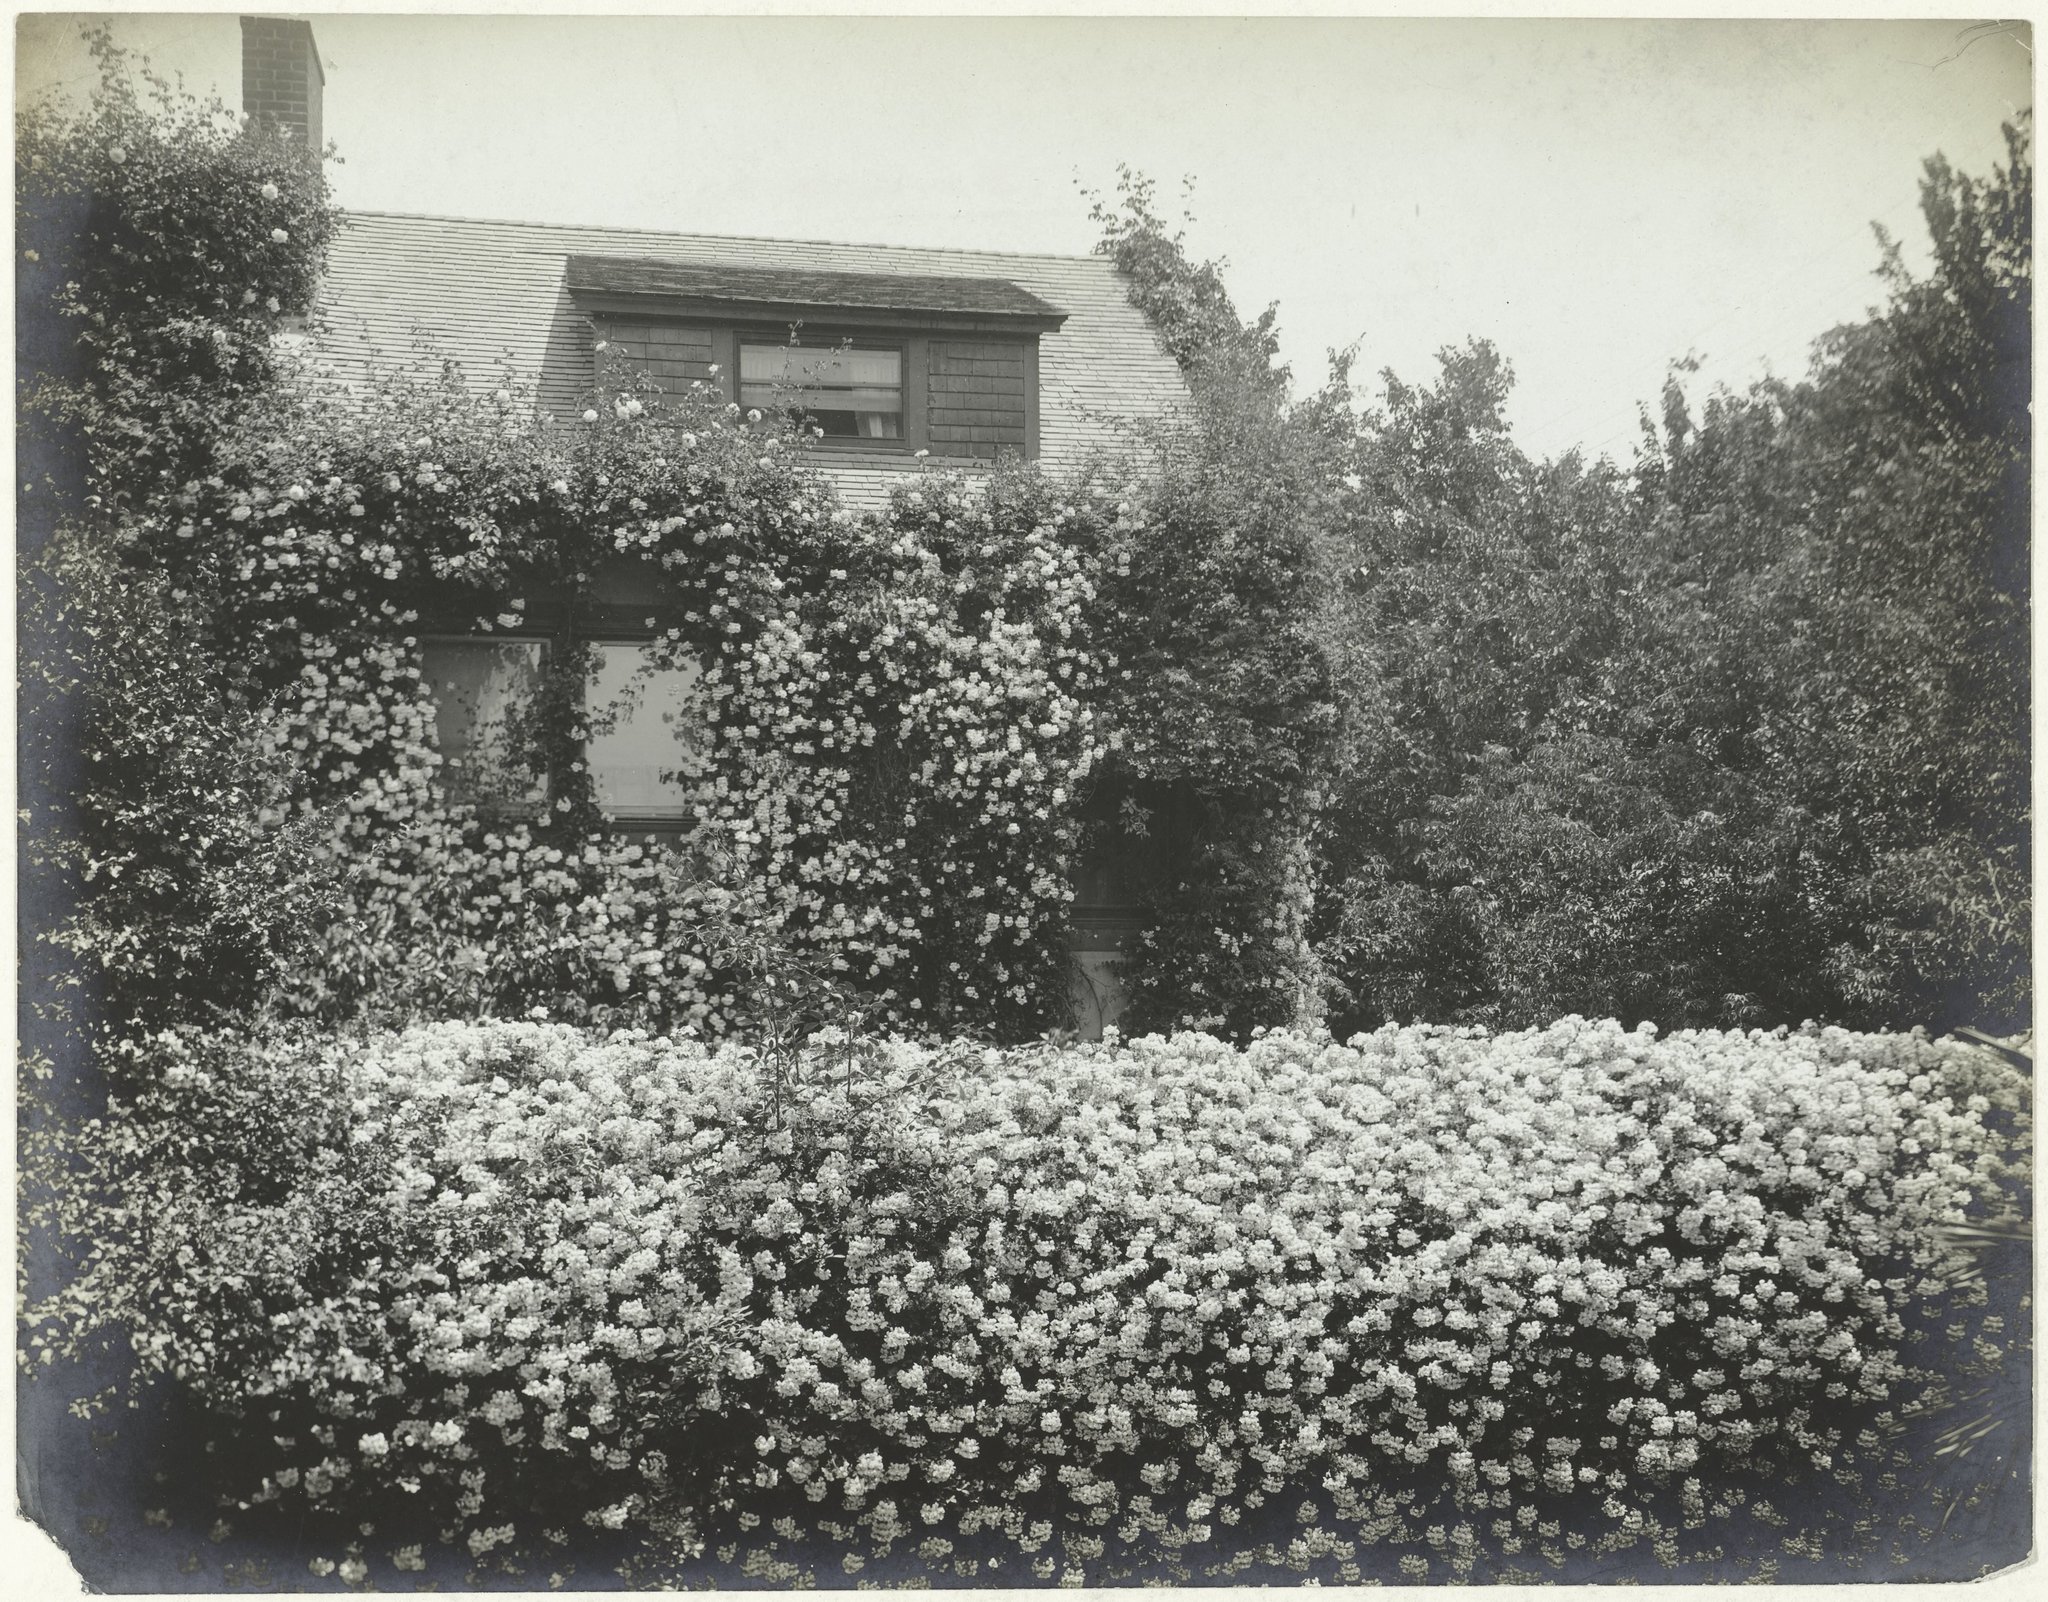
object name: photograph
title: Tuin en huis begroeid met rozenstruiken, Berkeley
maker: Anonymous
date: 1890-1920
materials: paper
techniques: gelatin silver print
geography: berkeley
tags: shrubs, garden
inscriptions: stamp: ‘On Line Southern Pacific’, inscription: ‘Roses-/ Berkeley/ California’, stamp: ‘This negative made by and property/ of, Southern Pacific Co. (...) San Francisco’, number: ‘1309’